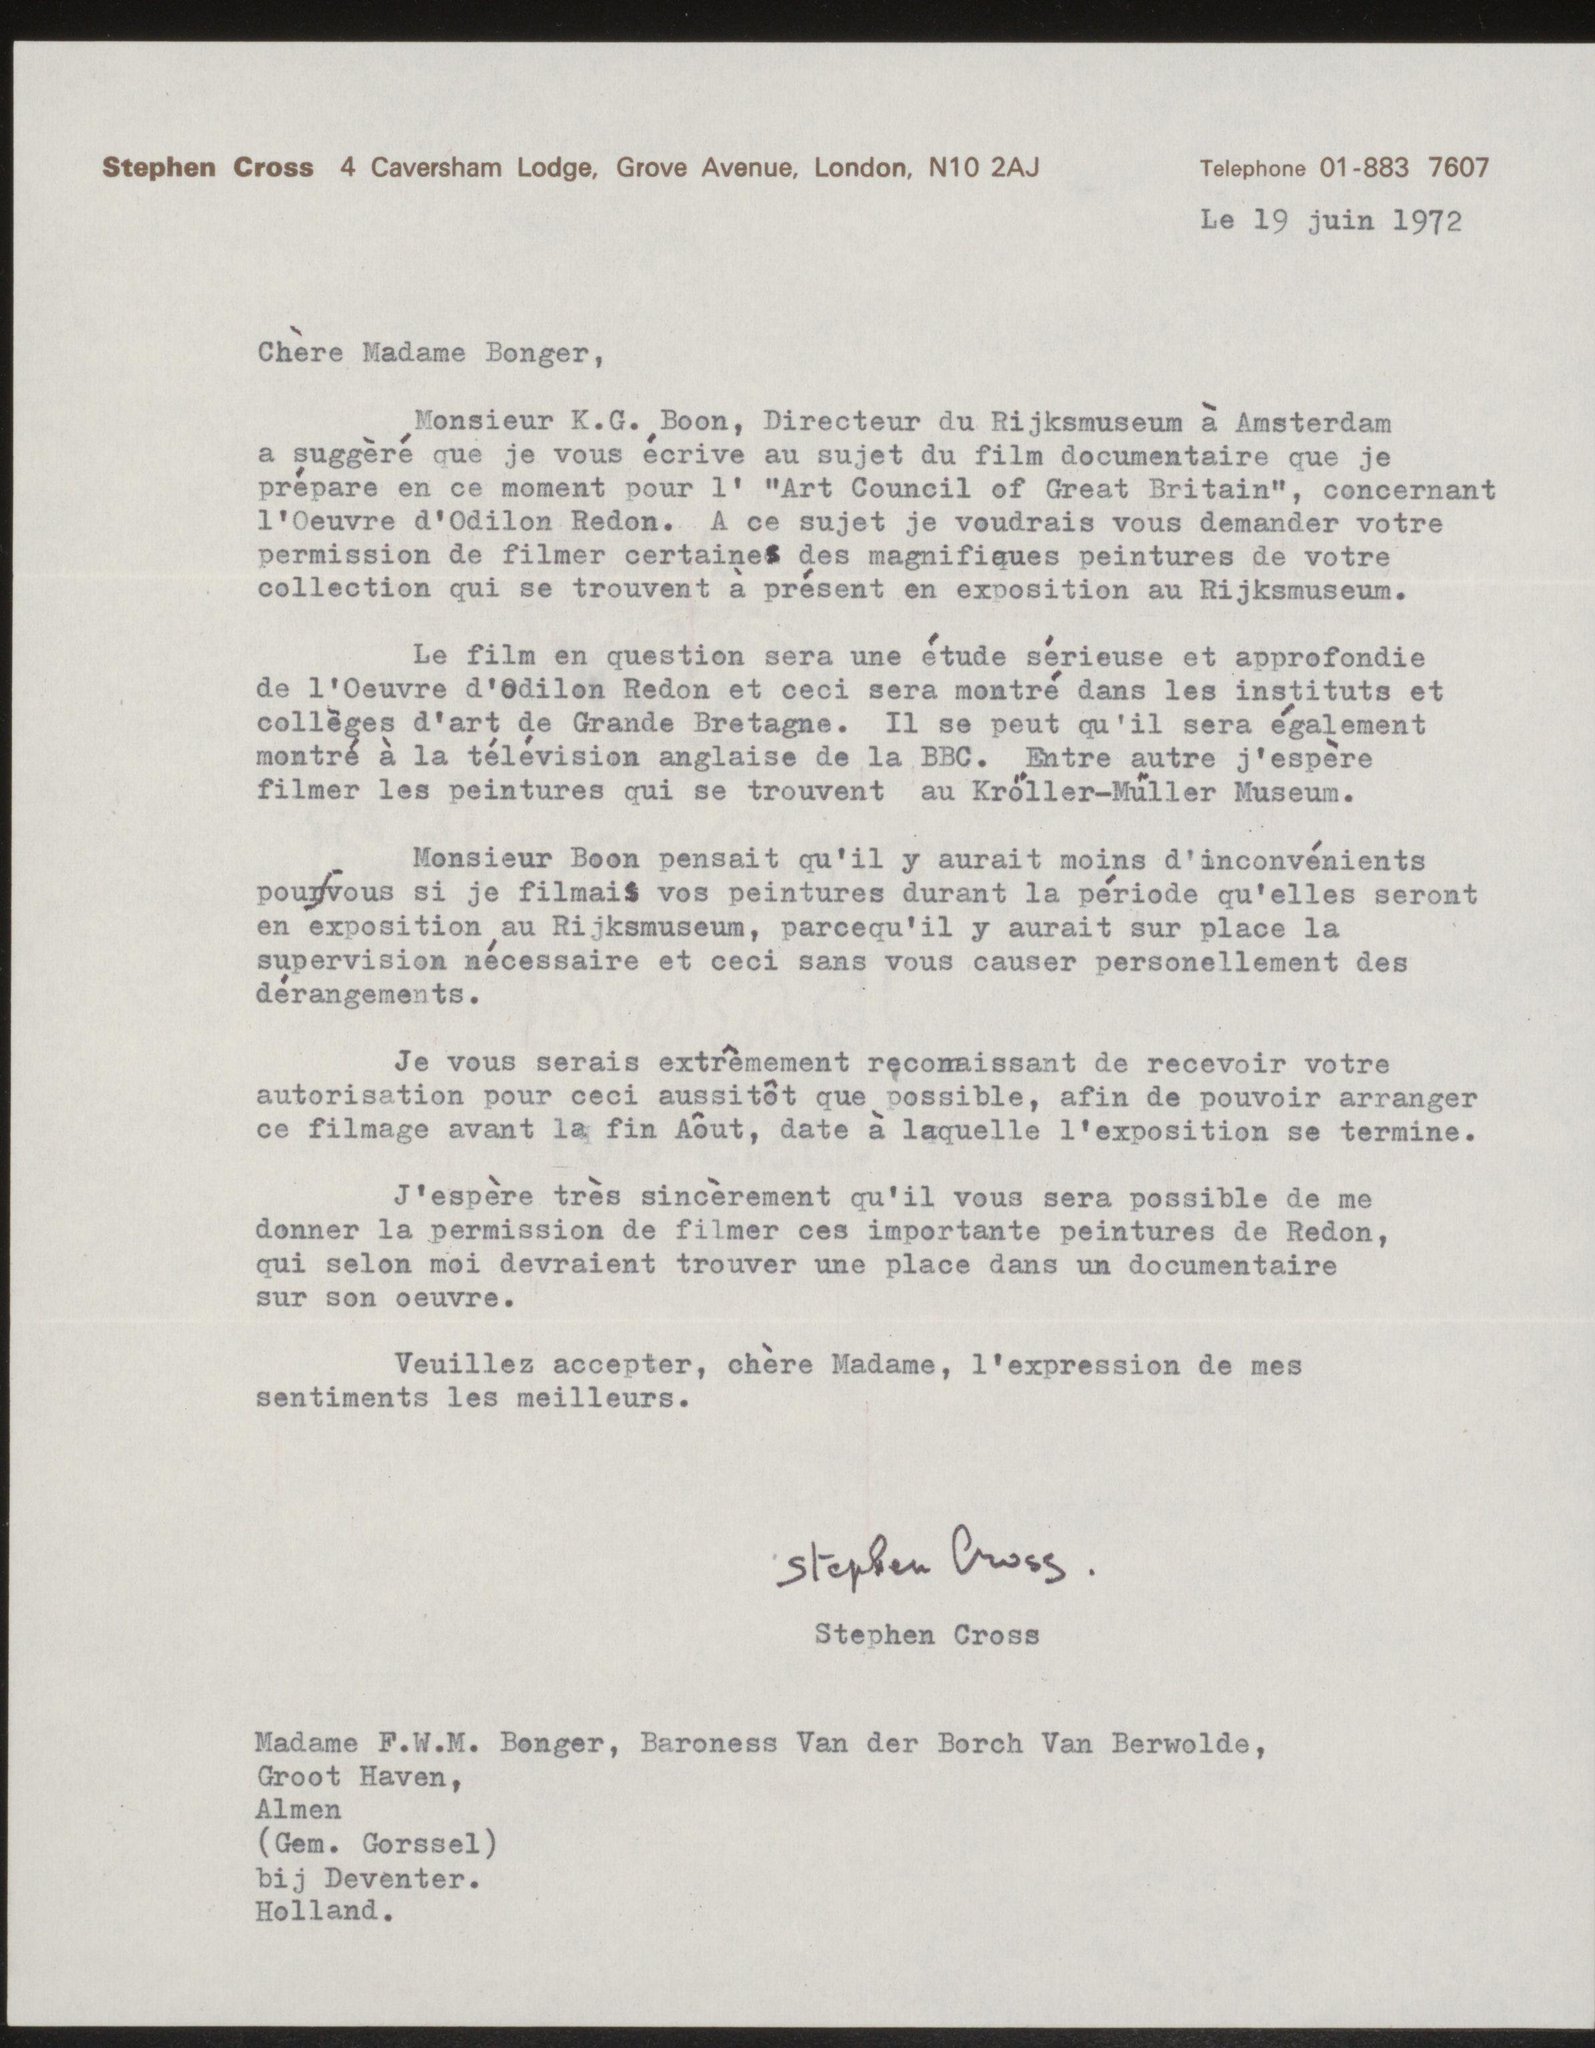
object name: letter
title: Brief aan Françoise W.M. Bonger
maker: stephen cross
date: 1972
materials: ink, paper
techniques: pen, printing, typewriting, writing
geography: london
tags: paris, draughtsman, odilon redon, karel gerard boon, françoise w.m. bonger, rijksmuseum amsterdam, painting (including book-illumination, miniature-painting), exhibition ~ art, art collecting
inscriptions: watermark